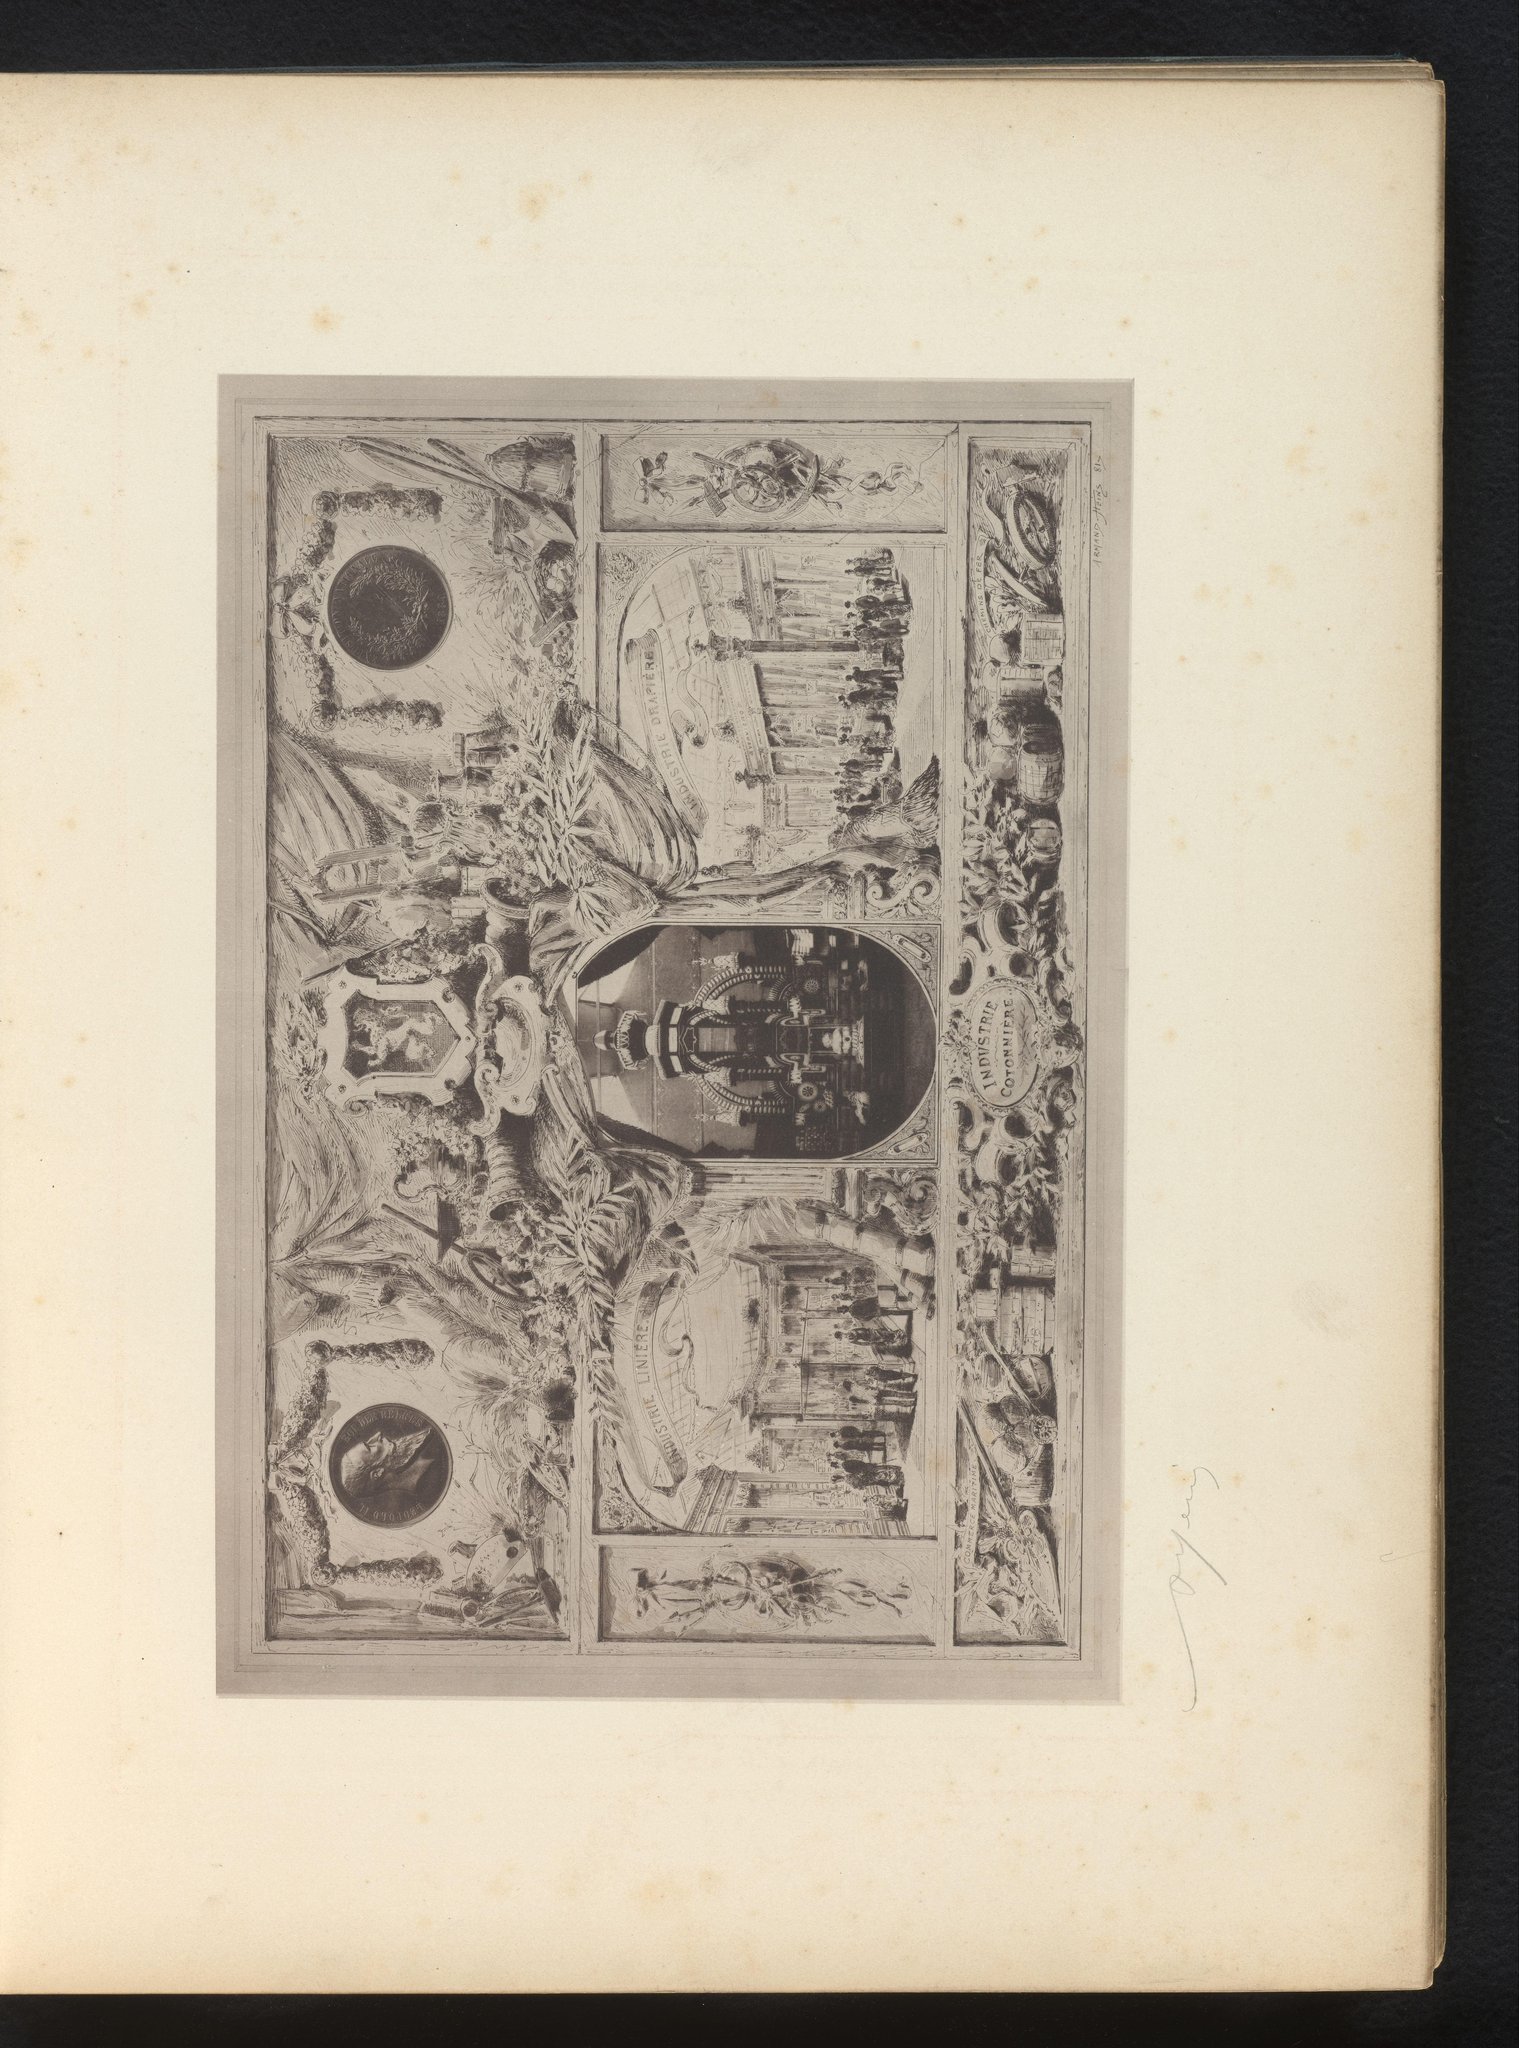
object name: photomechanical print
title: Reproductie van een gravure van de Exposition Nationale van 1880 in Brussel, omringd door tekeningen en een portret van Léopold II, door Armand Heins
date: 1881-1882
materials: paper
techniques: photograph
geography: brussels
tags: brussels, laeken, leopold ii (koning der belgen), trade exhibition, industries fair, king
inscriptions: name: ‘Heins’